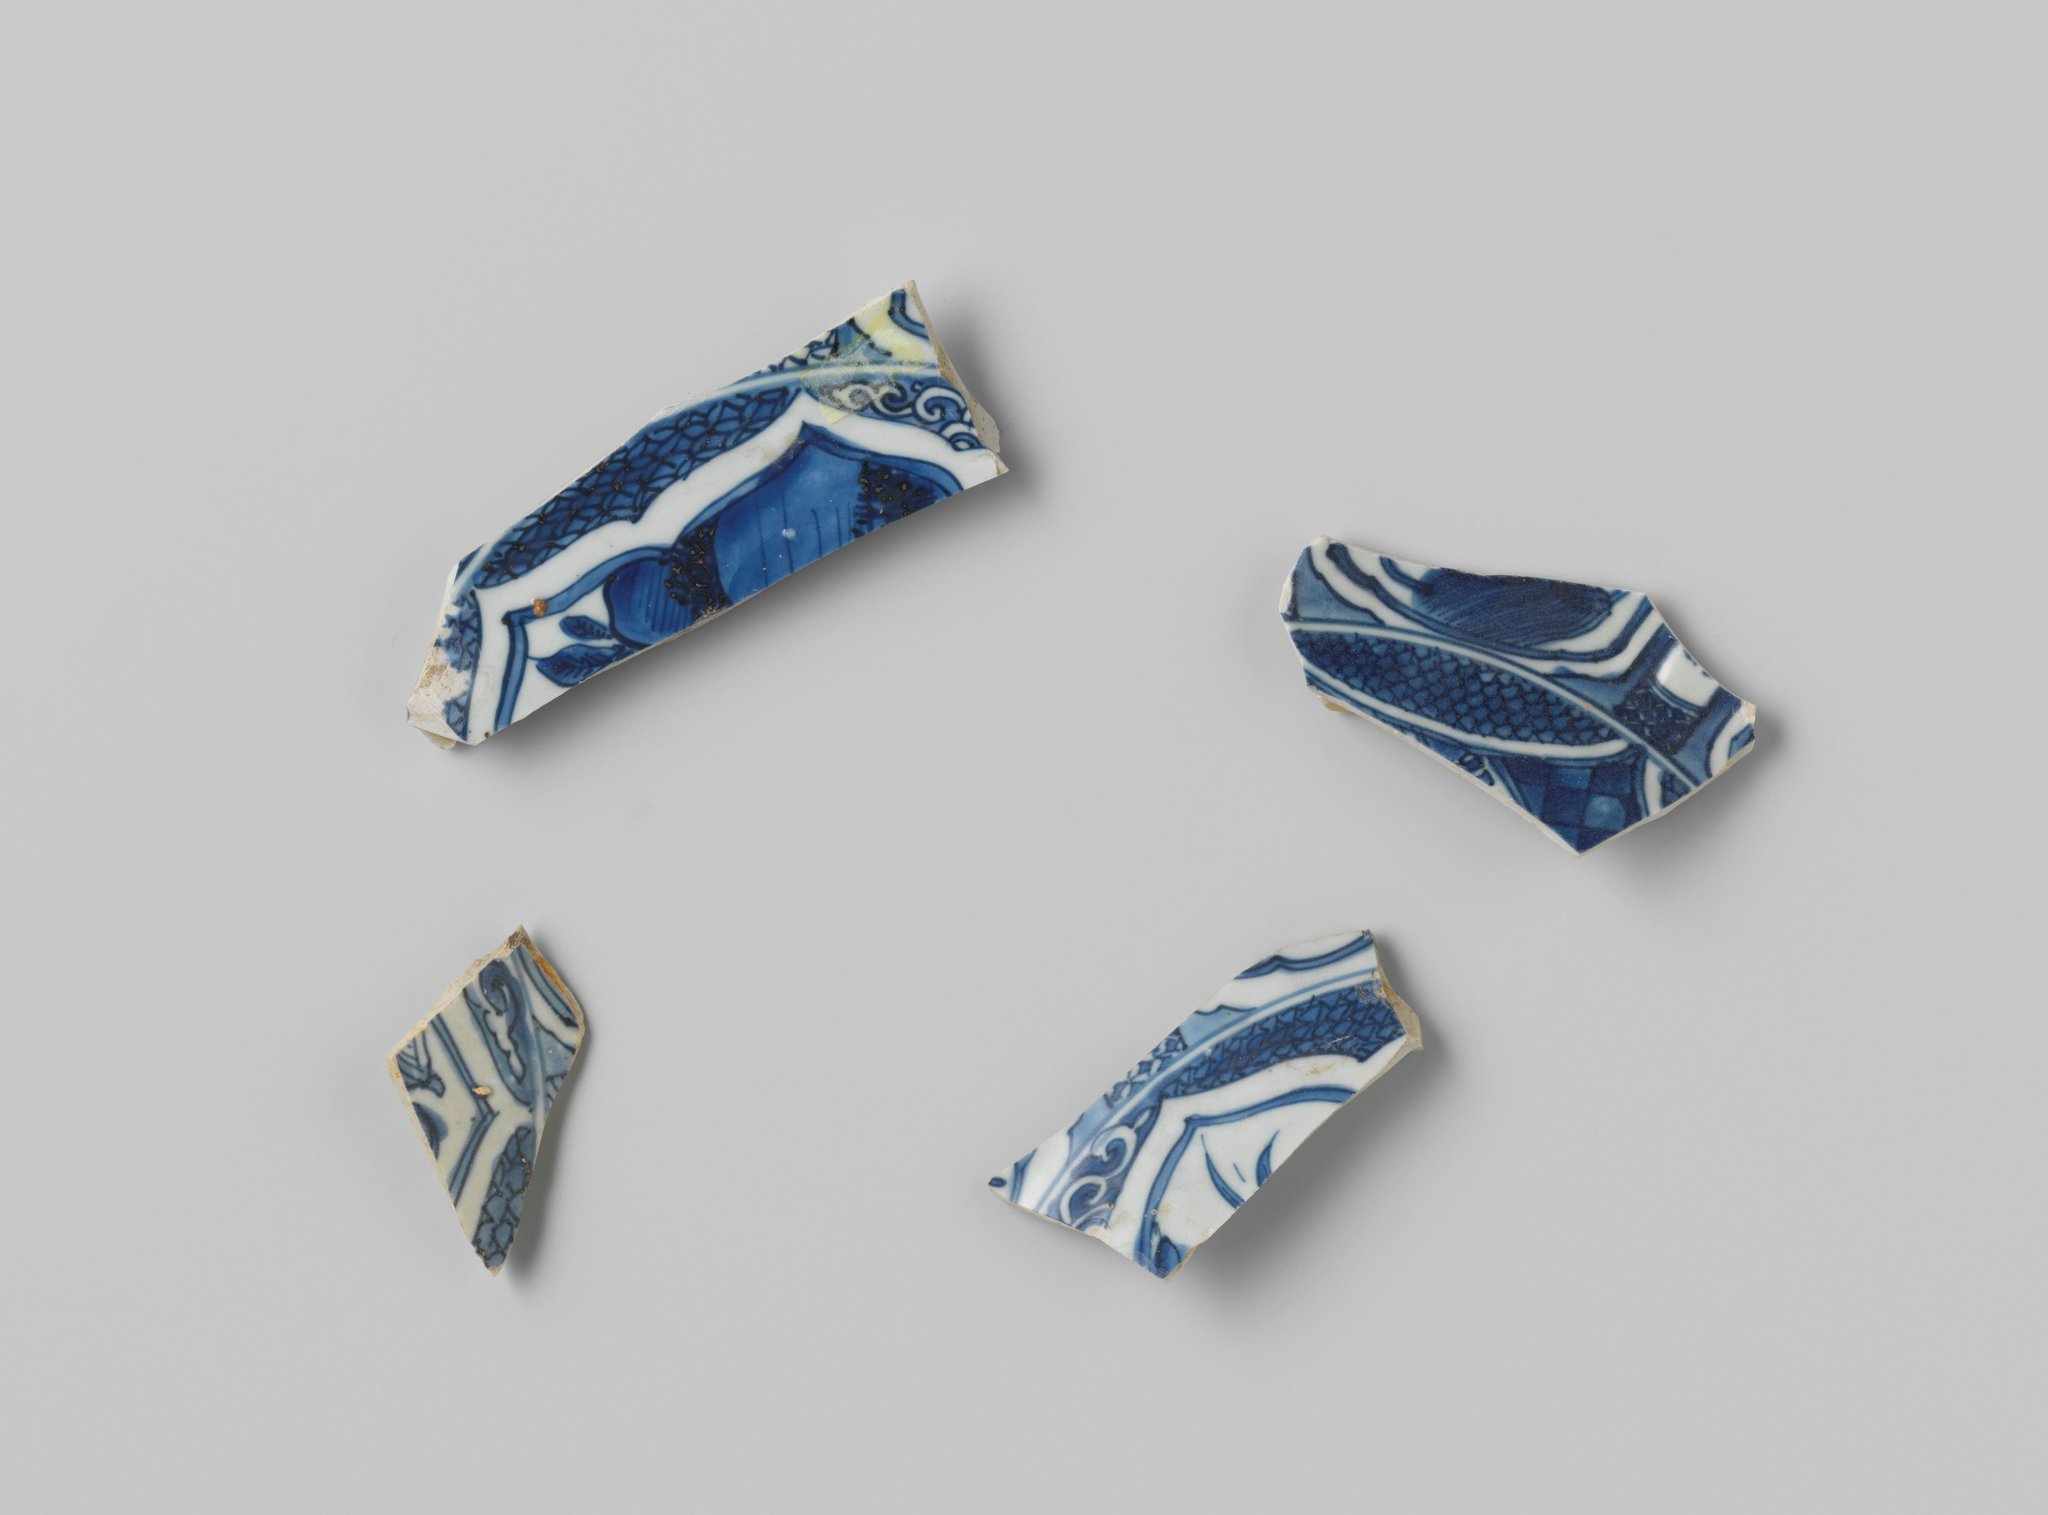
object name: plate dish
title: Scherven van borden uit V.O.C.-schip de 'Witte Leeuw'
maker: Anonymous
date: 1613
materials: bone china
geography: jingdezhen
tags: verenigde oostindische compagnie, sint-helena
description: Scherven van borden uit V.O.C.-schip de 'Witte Leeuw' van kraakporselein.